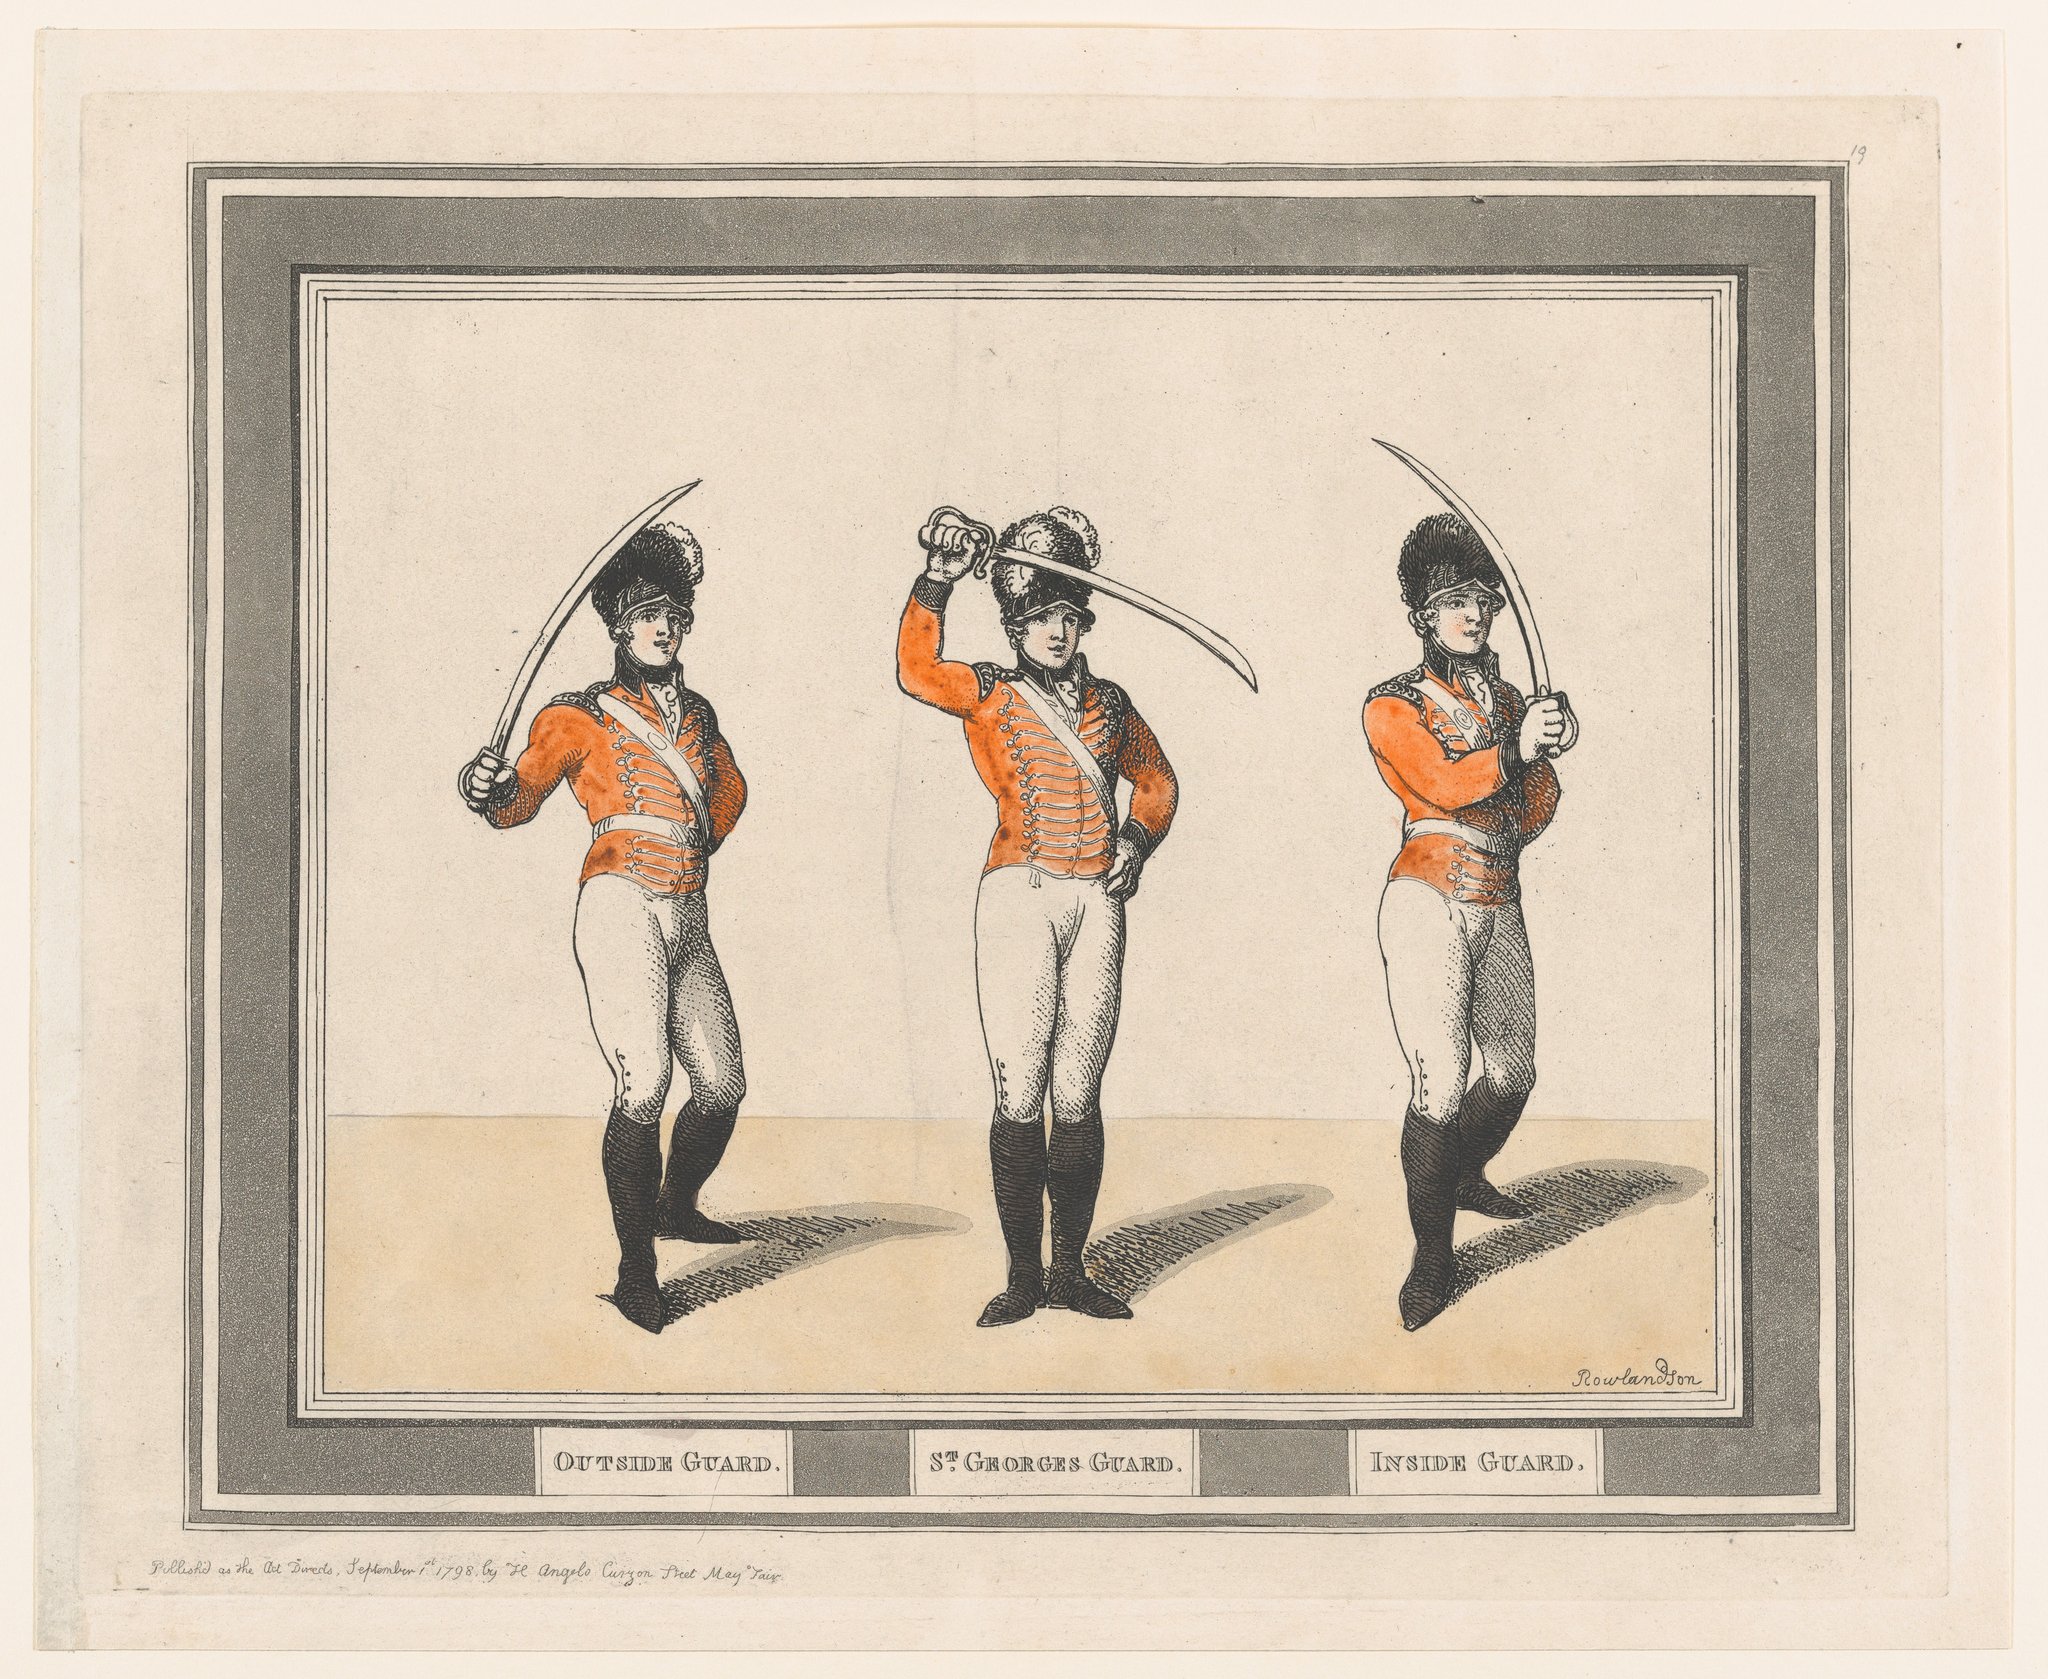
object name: print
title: Outside Guard, St. Georges Guard, Inside Guard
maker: thomas rowlandson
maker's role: artist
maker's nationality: british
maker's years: 1757-1827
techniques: aquatint, etching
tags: swords,men